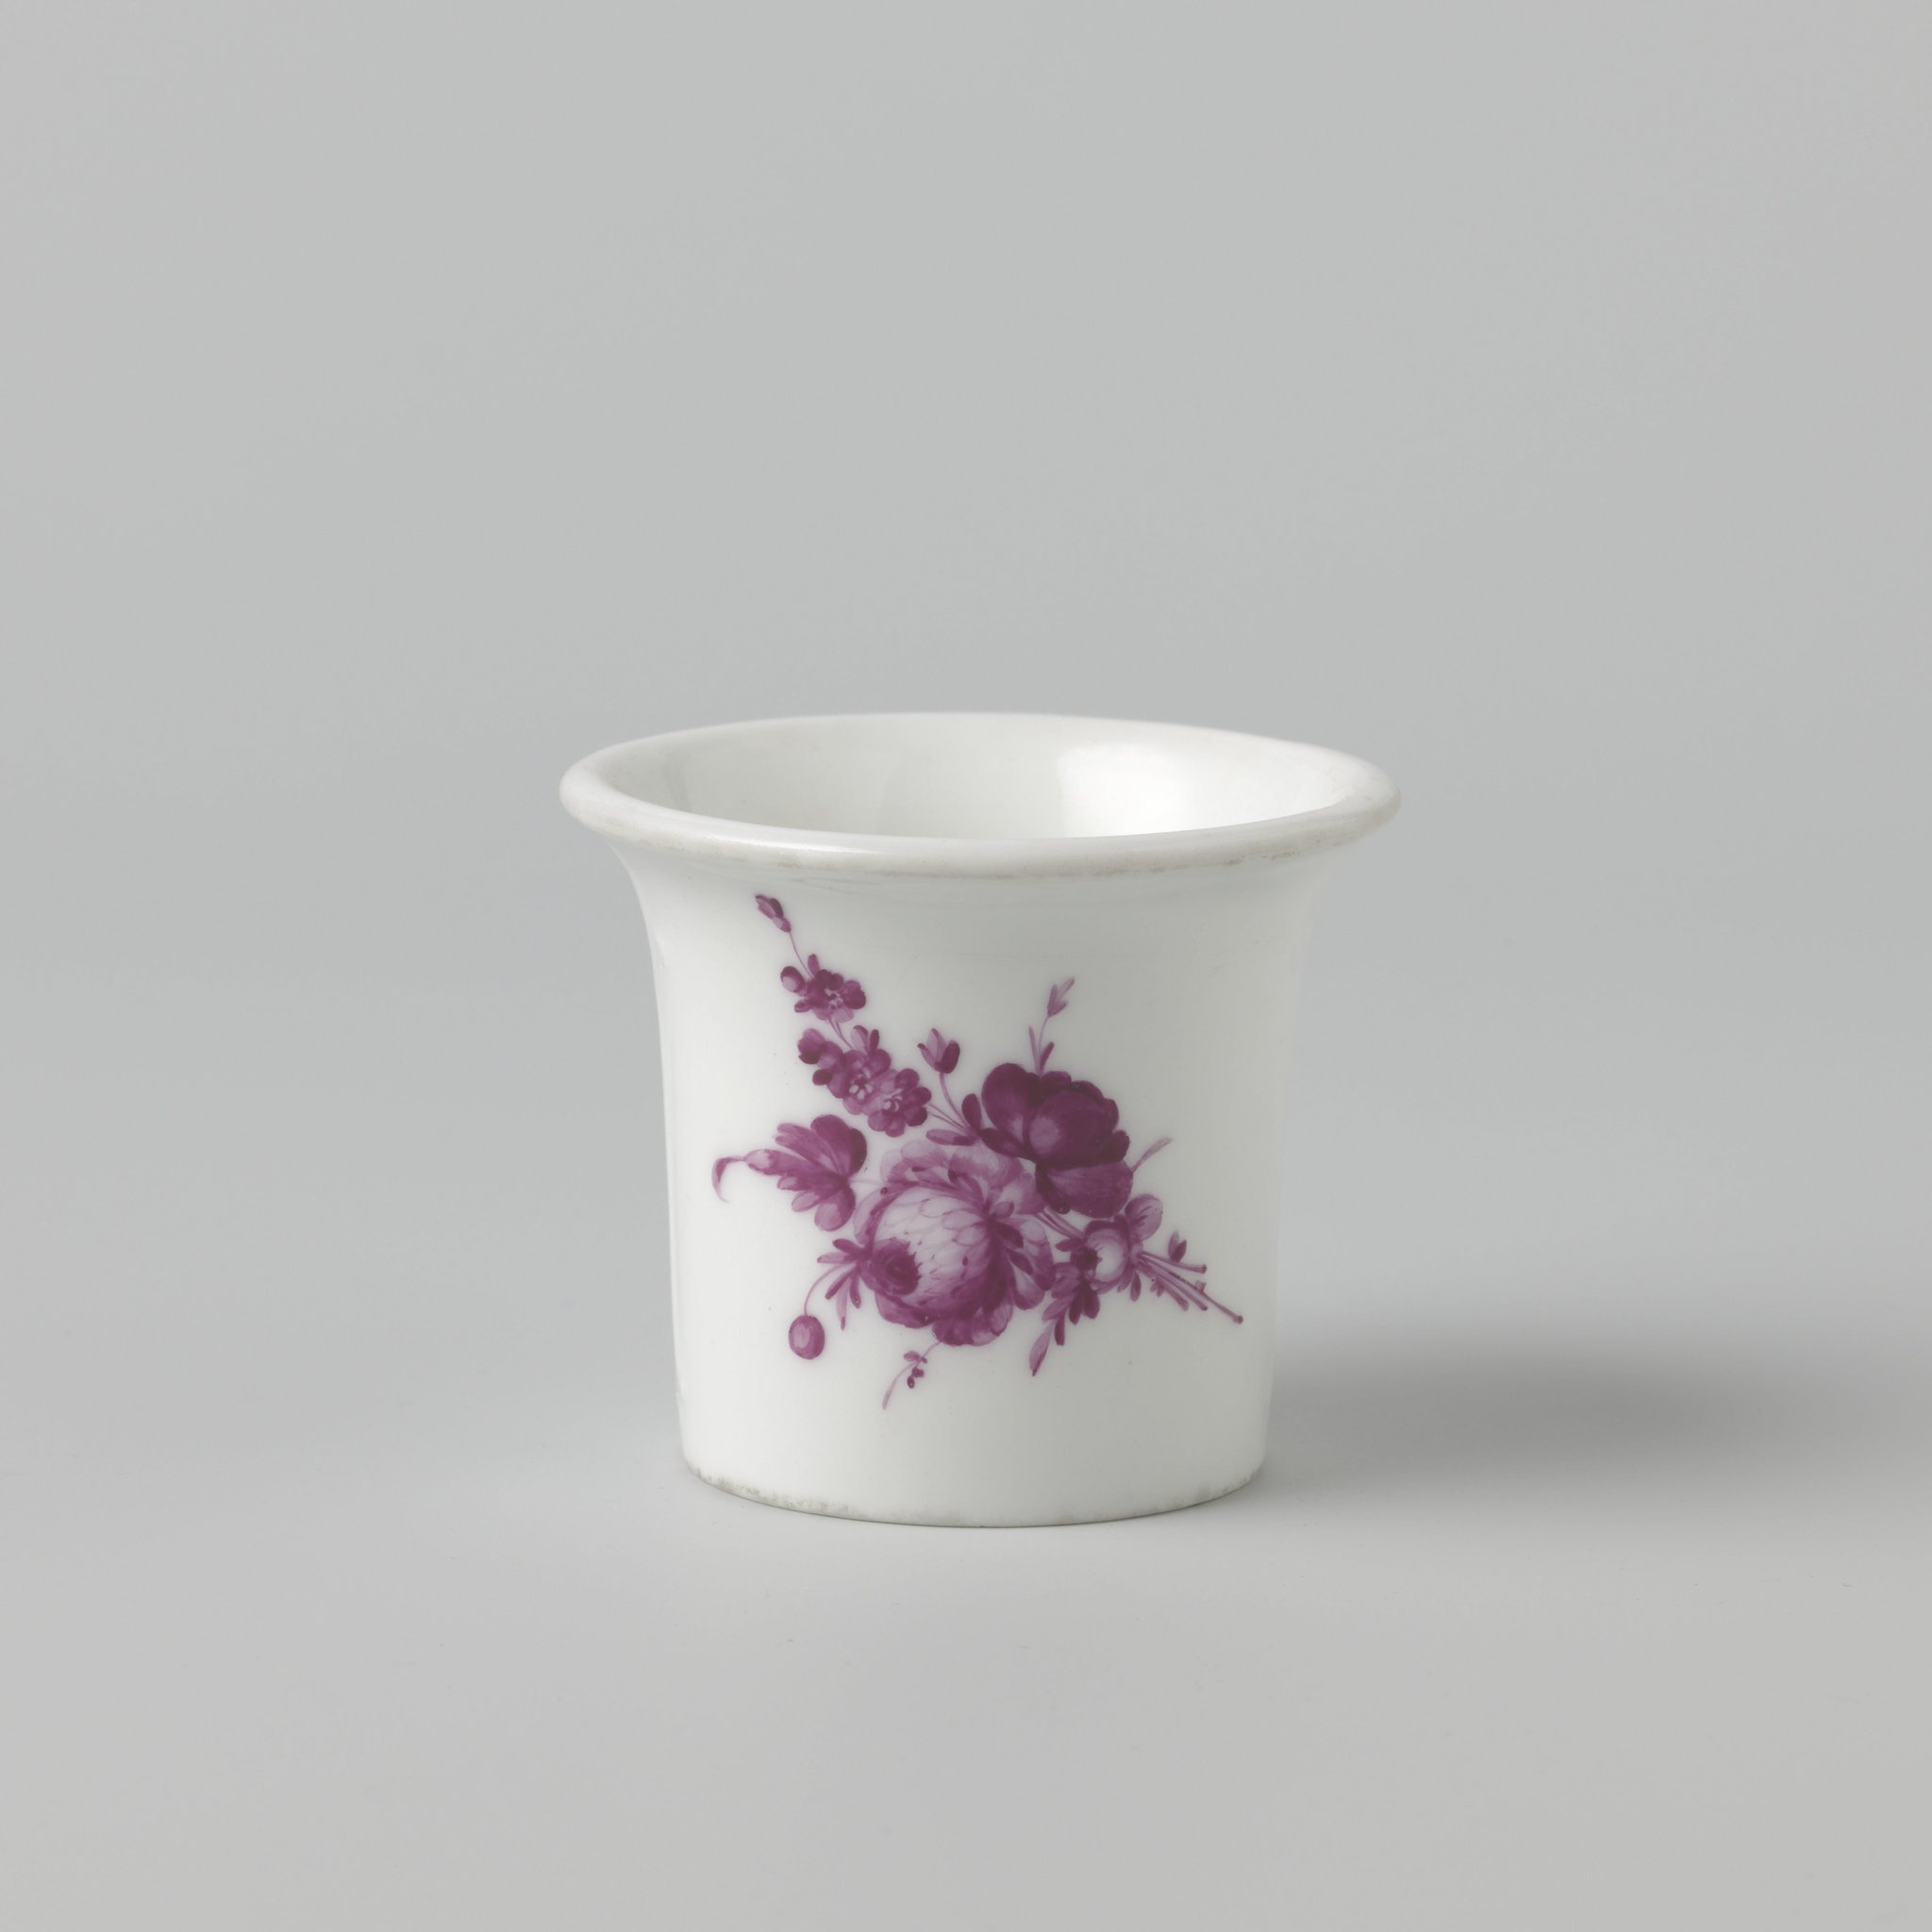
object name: flowerpot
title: Bloempot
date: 1784-1814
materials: porcelain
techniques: painted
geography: amstel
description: Bloempot veelkleurig beschilderd met een bloemboeket. Gemerkt: Lo3 ingekrast in blauw.